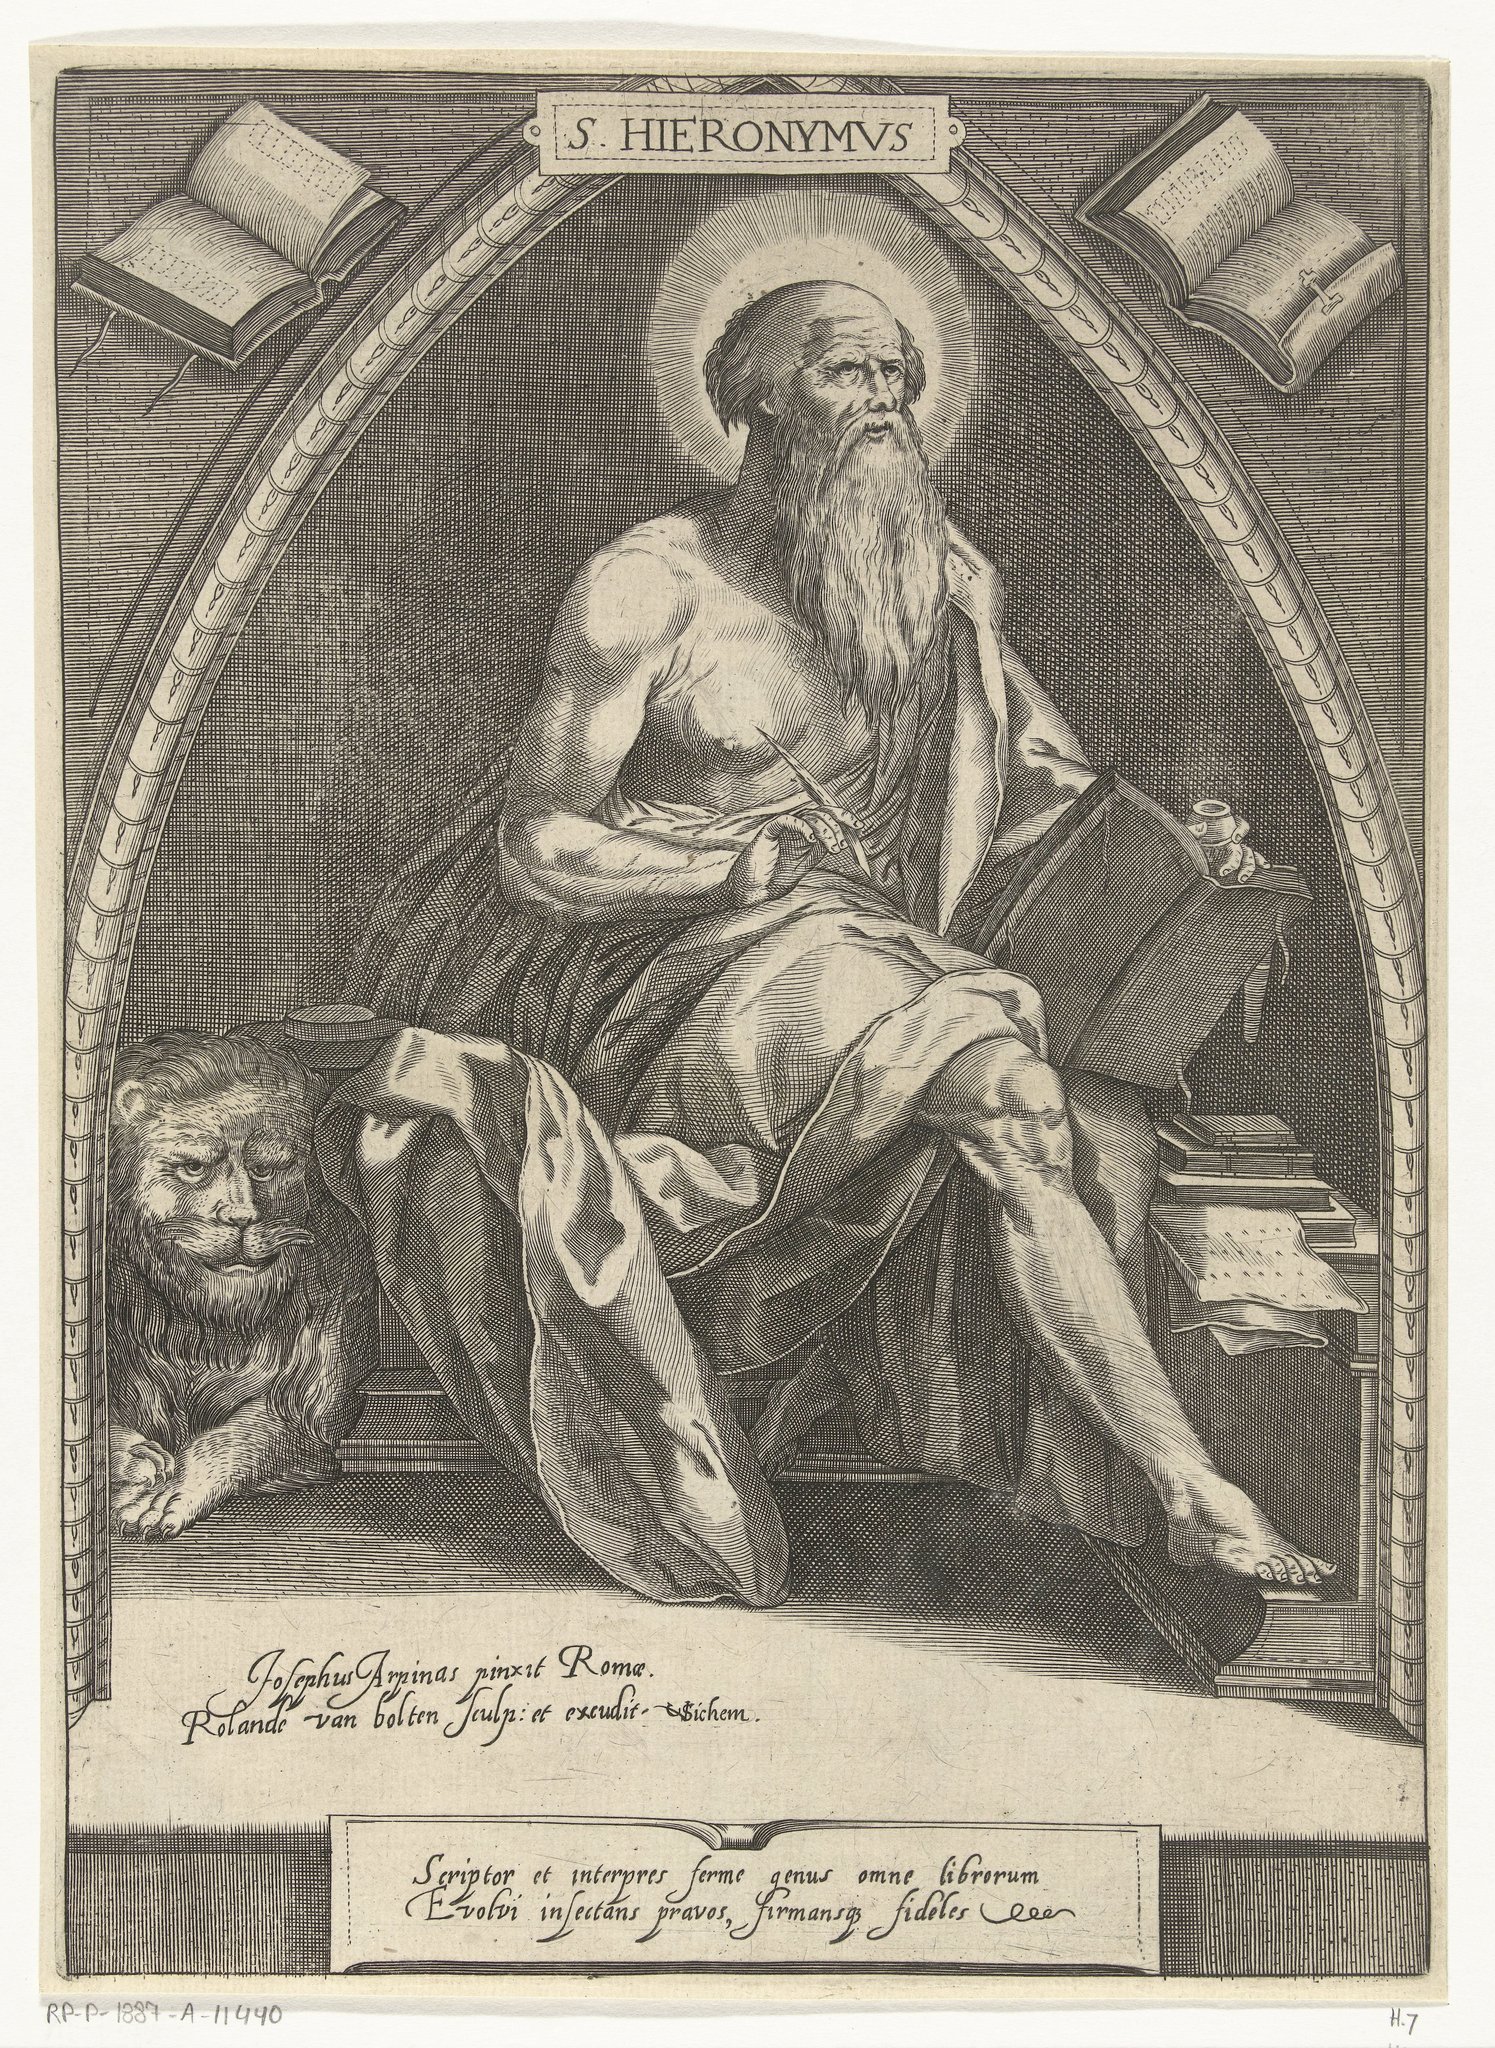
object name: print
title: De vier kerkvaders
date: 1600-1608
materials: paper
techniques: engraving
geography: zwolle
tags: st. jerome as doctor of the latin church in his study with book, pen and ink; lion and cardinal's hat beside him, the four latin (western) fathers of the church together: ambrose (usually as bishop), jerome (usually as cardinal), augustine (usually as bishop), gregory the great (usually as pope)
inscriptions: collector's mark: Lugt 2228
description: De H. Hieronymus gezeten in een kerkgewelf. Hij is half naakt, maar draagt nog zijn kardinaalsgewaad. Zijn kardinaalshoed ligt naast hem op een bankje. Hij is aan het schrijven en zijn werkinstrumenten (inktpot, boeken, pen) zijn ook afgebeeld. De leeuw die hij ooit heeft geholpen, zijn persoonlijk attribuut, ligt naast hem. De prent draagt een opschrift met Hieronymus' naam en een Latijns onderschrift. De serie betreft de vier kerkvaders.